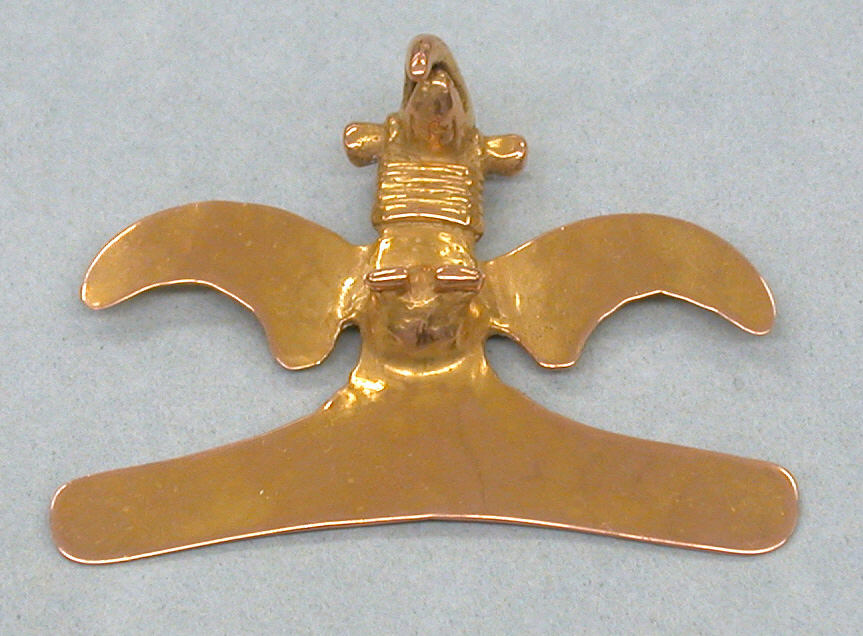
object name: pendant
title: Eagle Pendant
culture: veraguas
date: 1001-1600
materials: gold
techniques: casting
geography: costa rica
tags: eagles